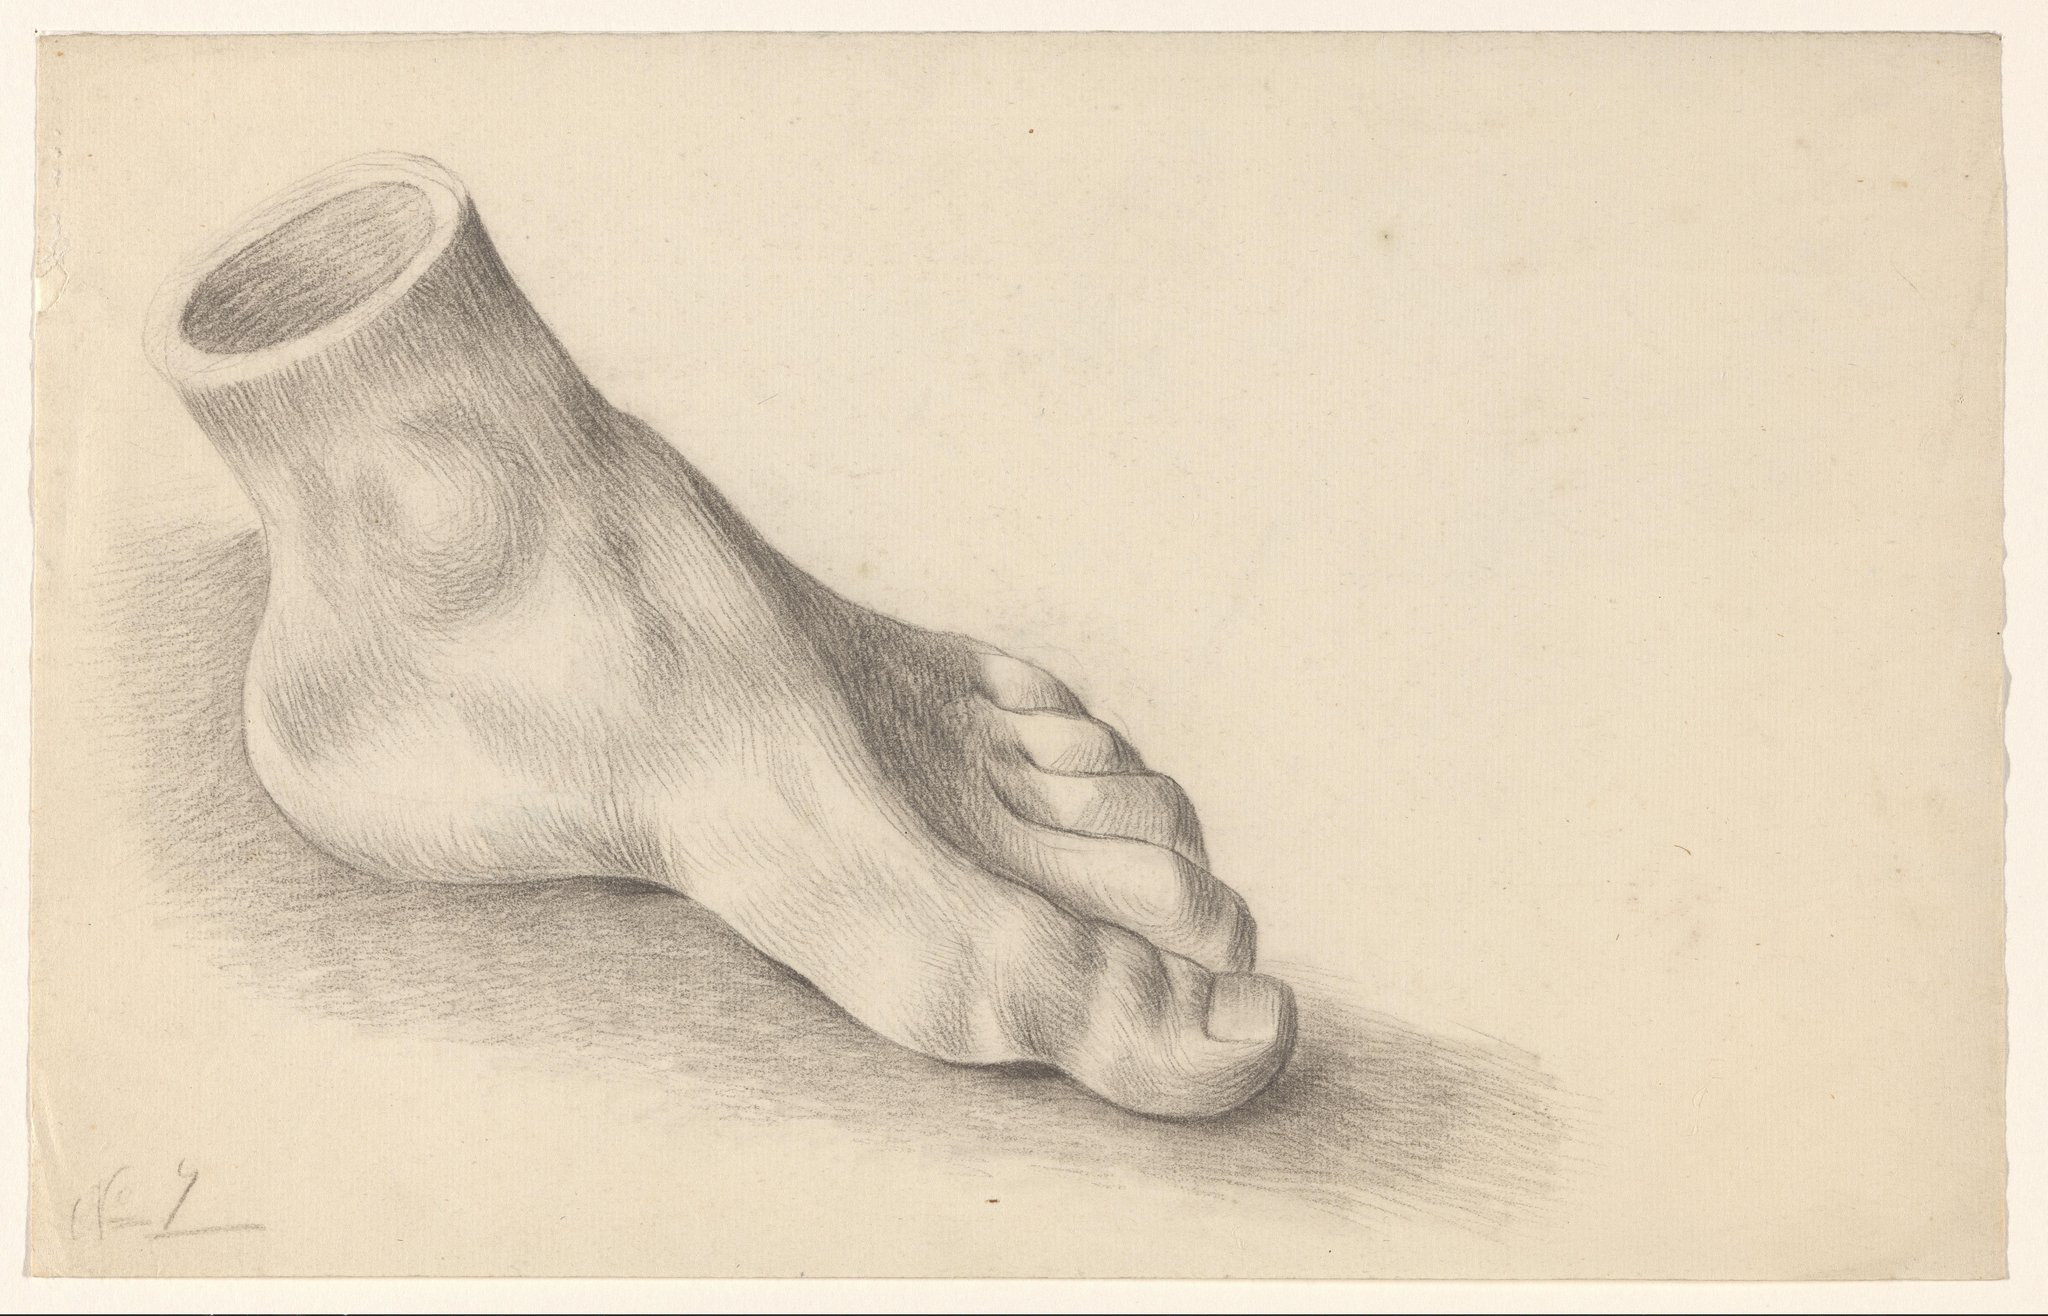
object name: drawing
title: Studie van een voet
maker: Anonymous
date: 1830-1880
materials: chalk, paper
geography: netherlands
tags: foot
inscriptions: inscription: ‘No 7’